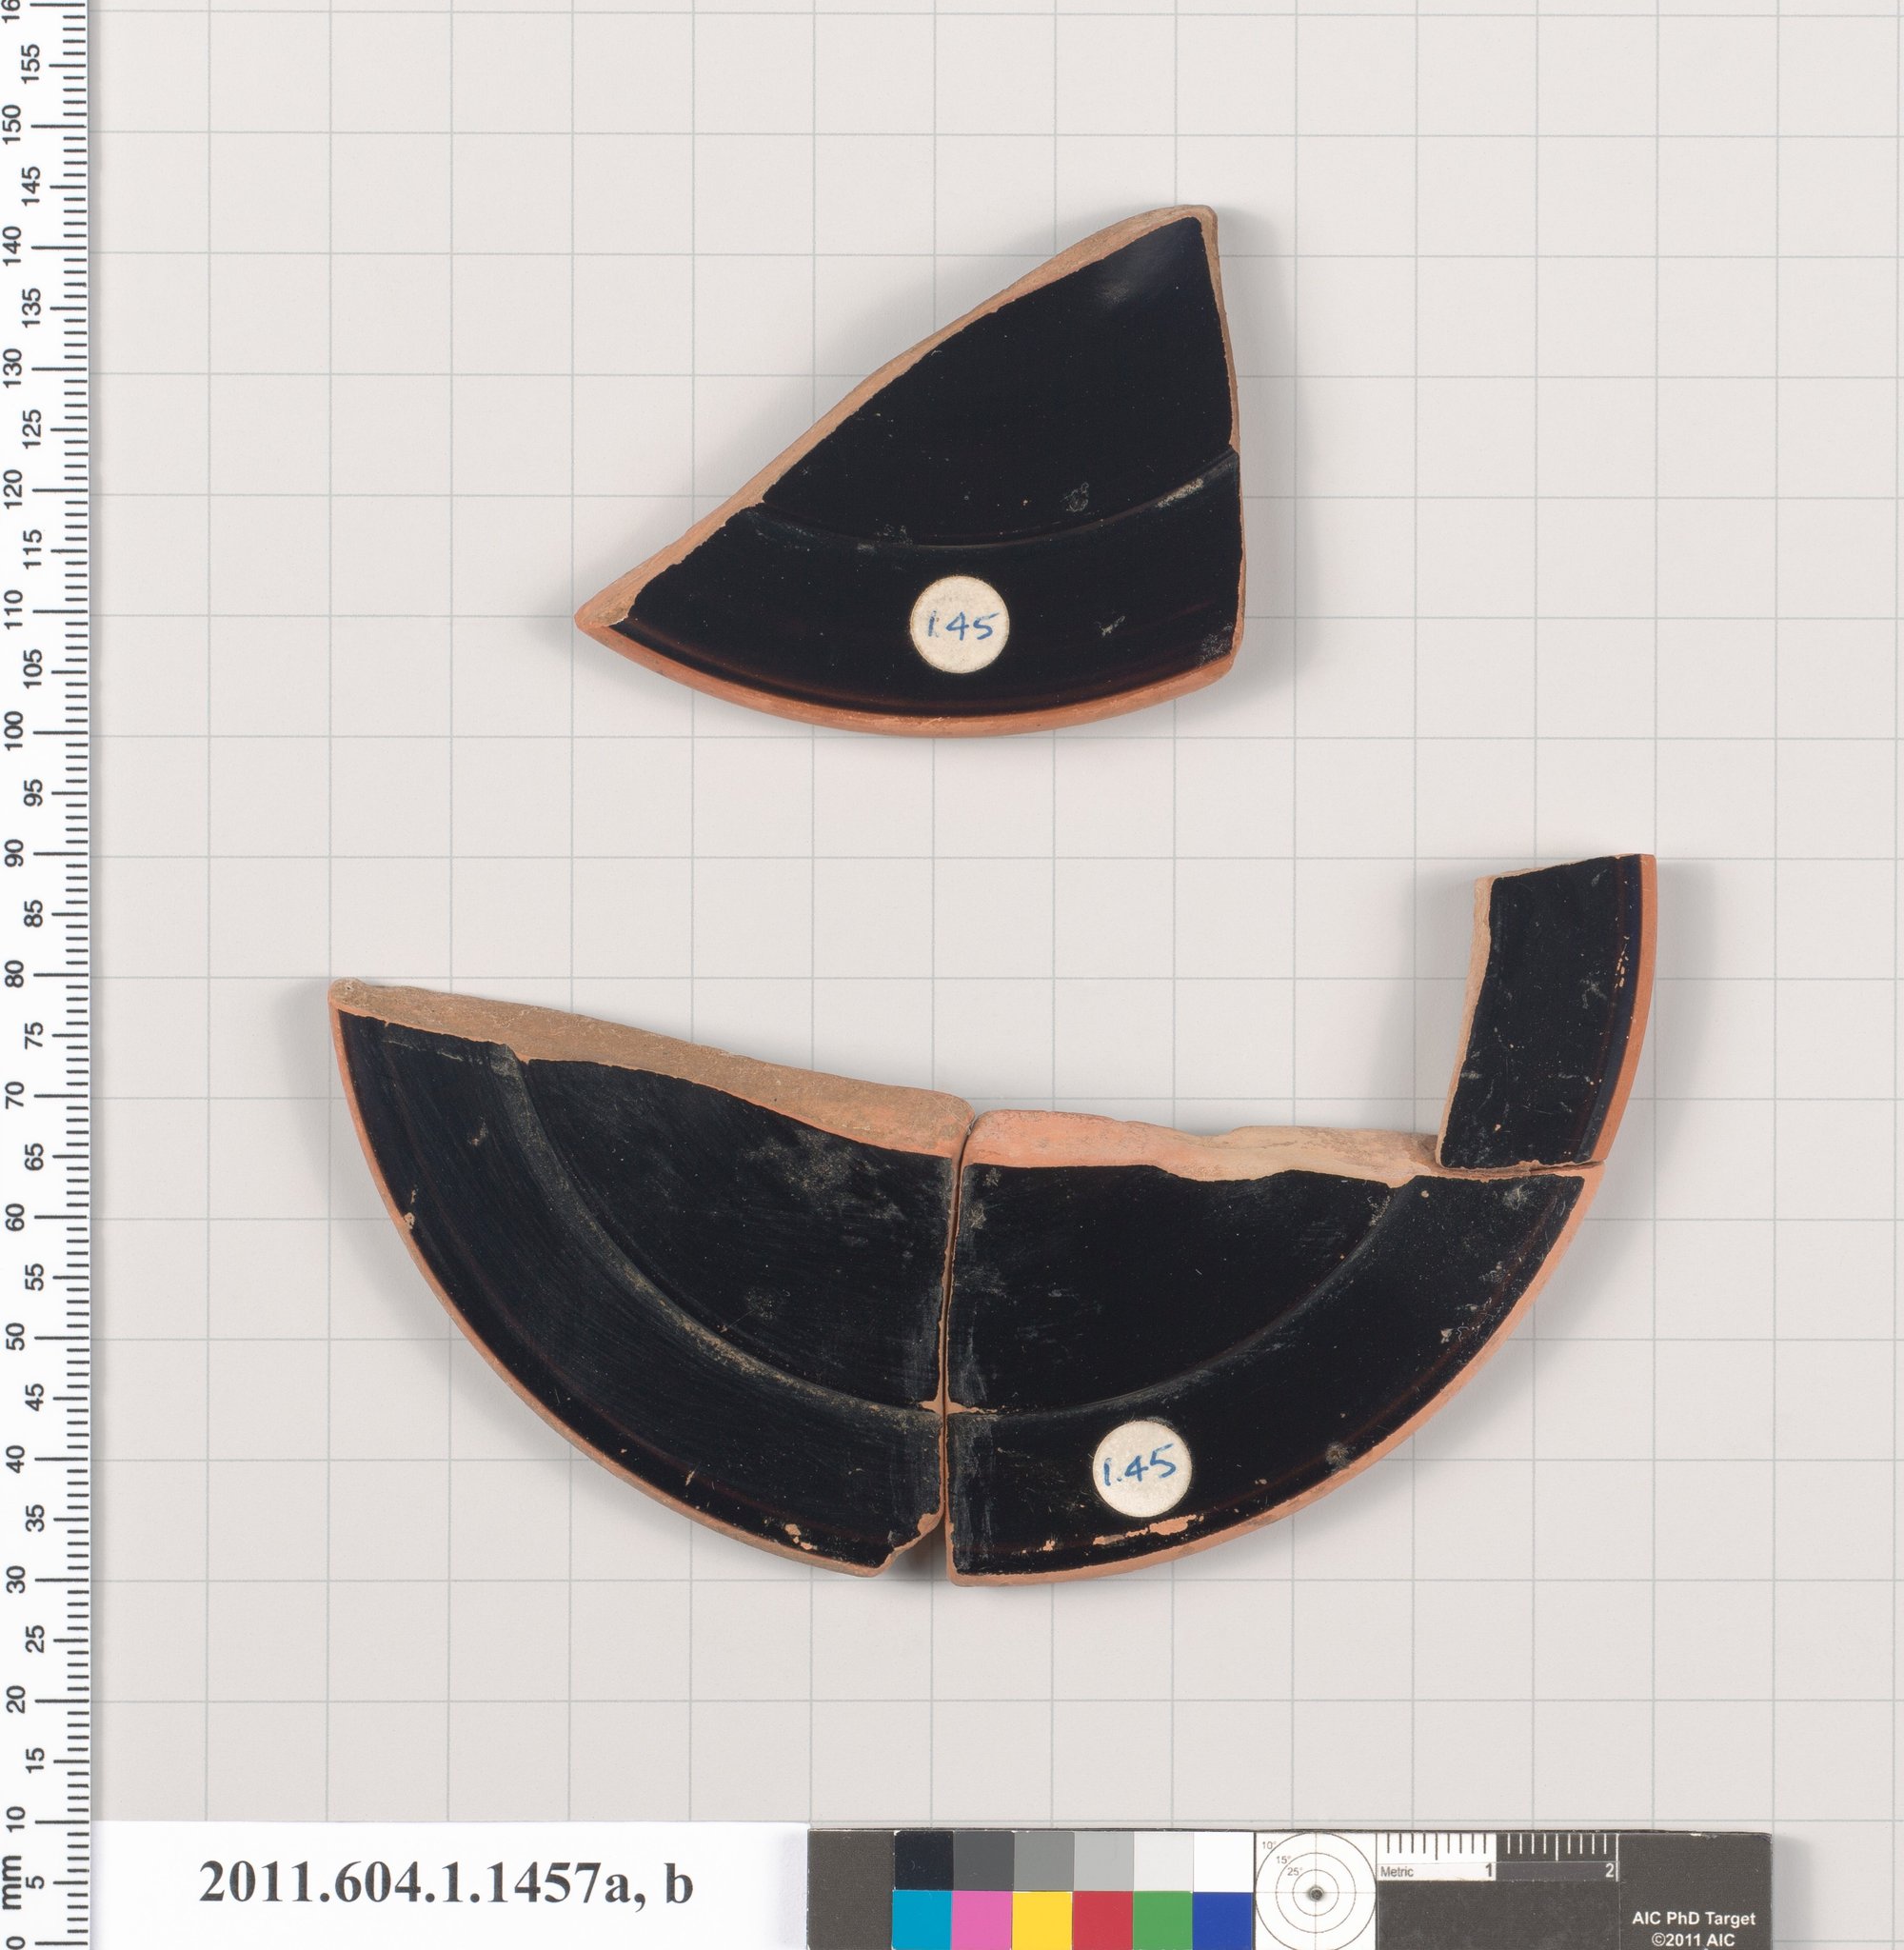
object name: kylix fragment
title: Terracotta fragments of a kylix (drinking cup)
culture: greek, attic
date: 500-401 BCE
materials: terracotta